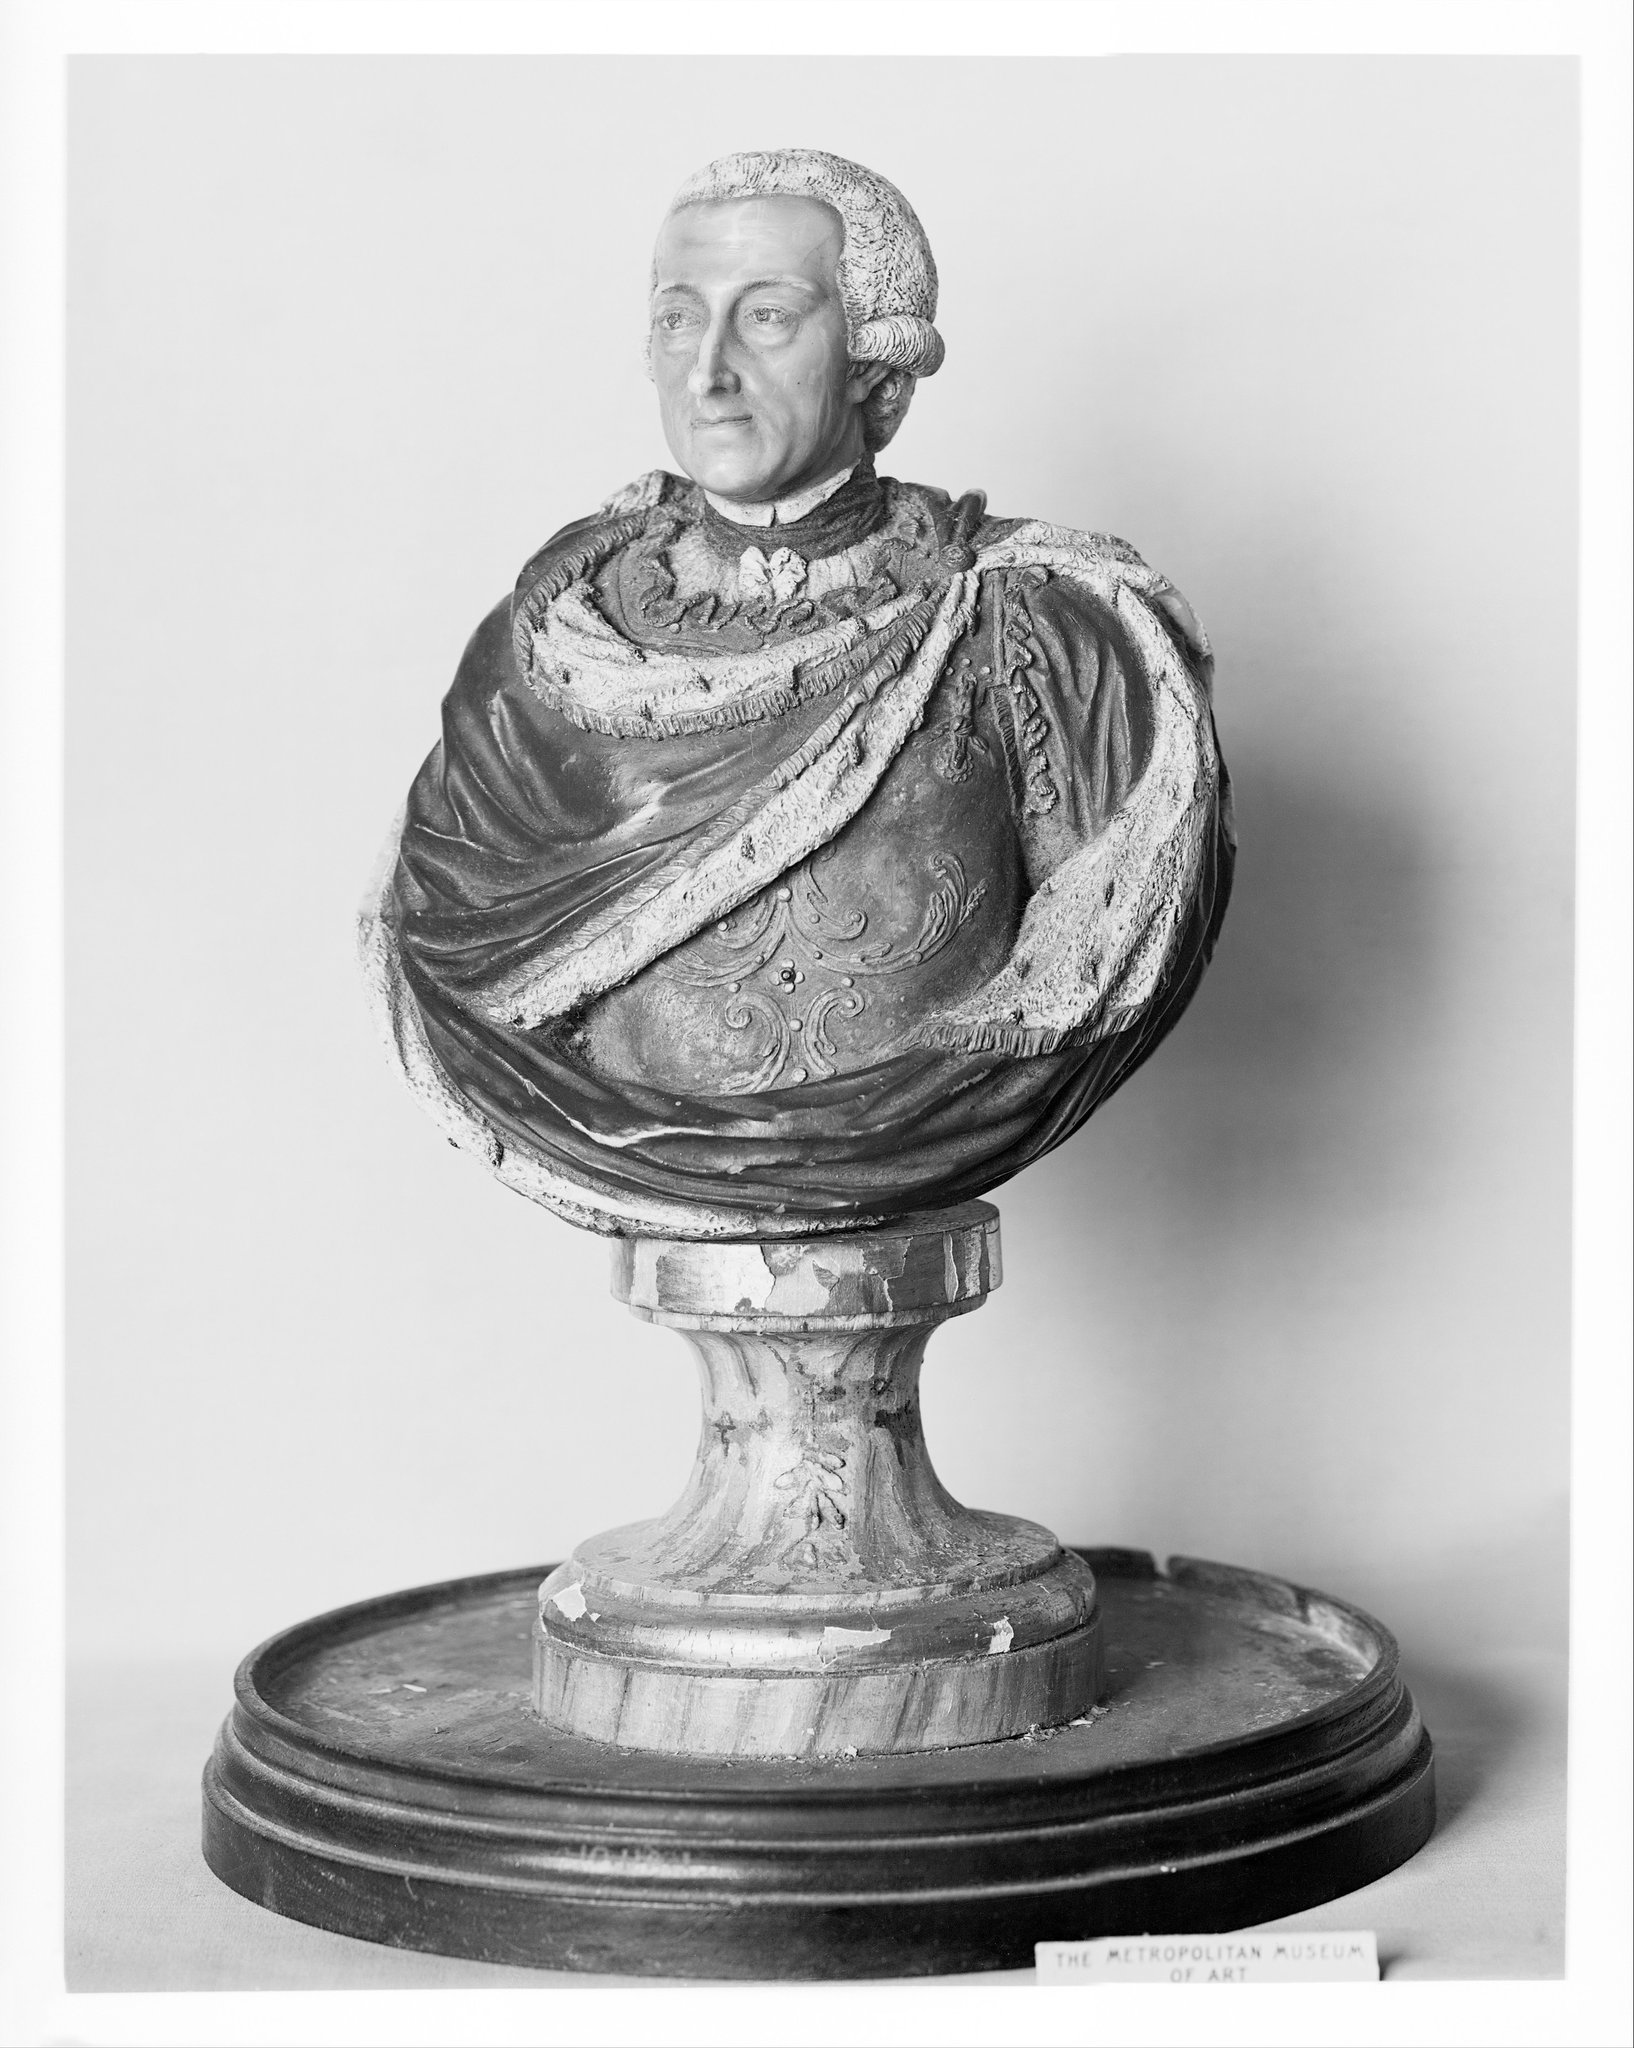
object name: bust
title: Victor Amadeus III of Savoy, IV of Sardinia (born 1726, reigned 1773–96)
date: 1767-1800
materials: wax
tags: kings,portraits